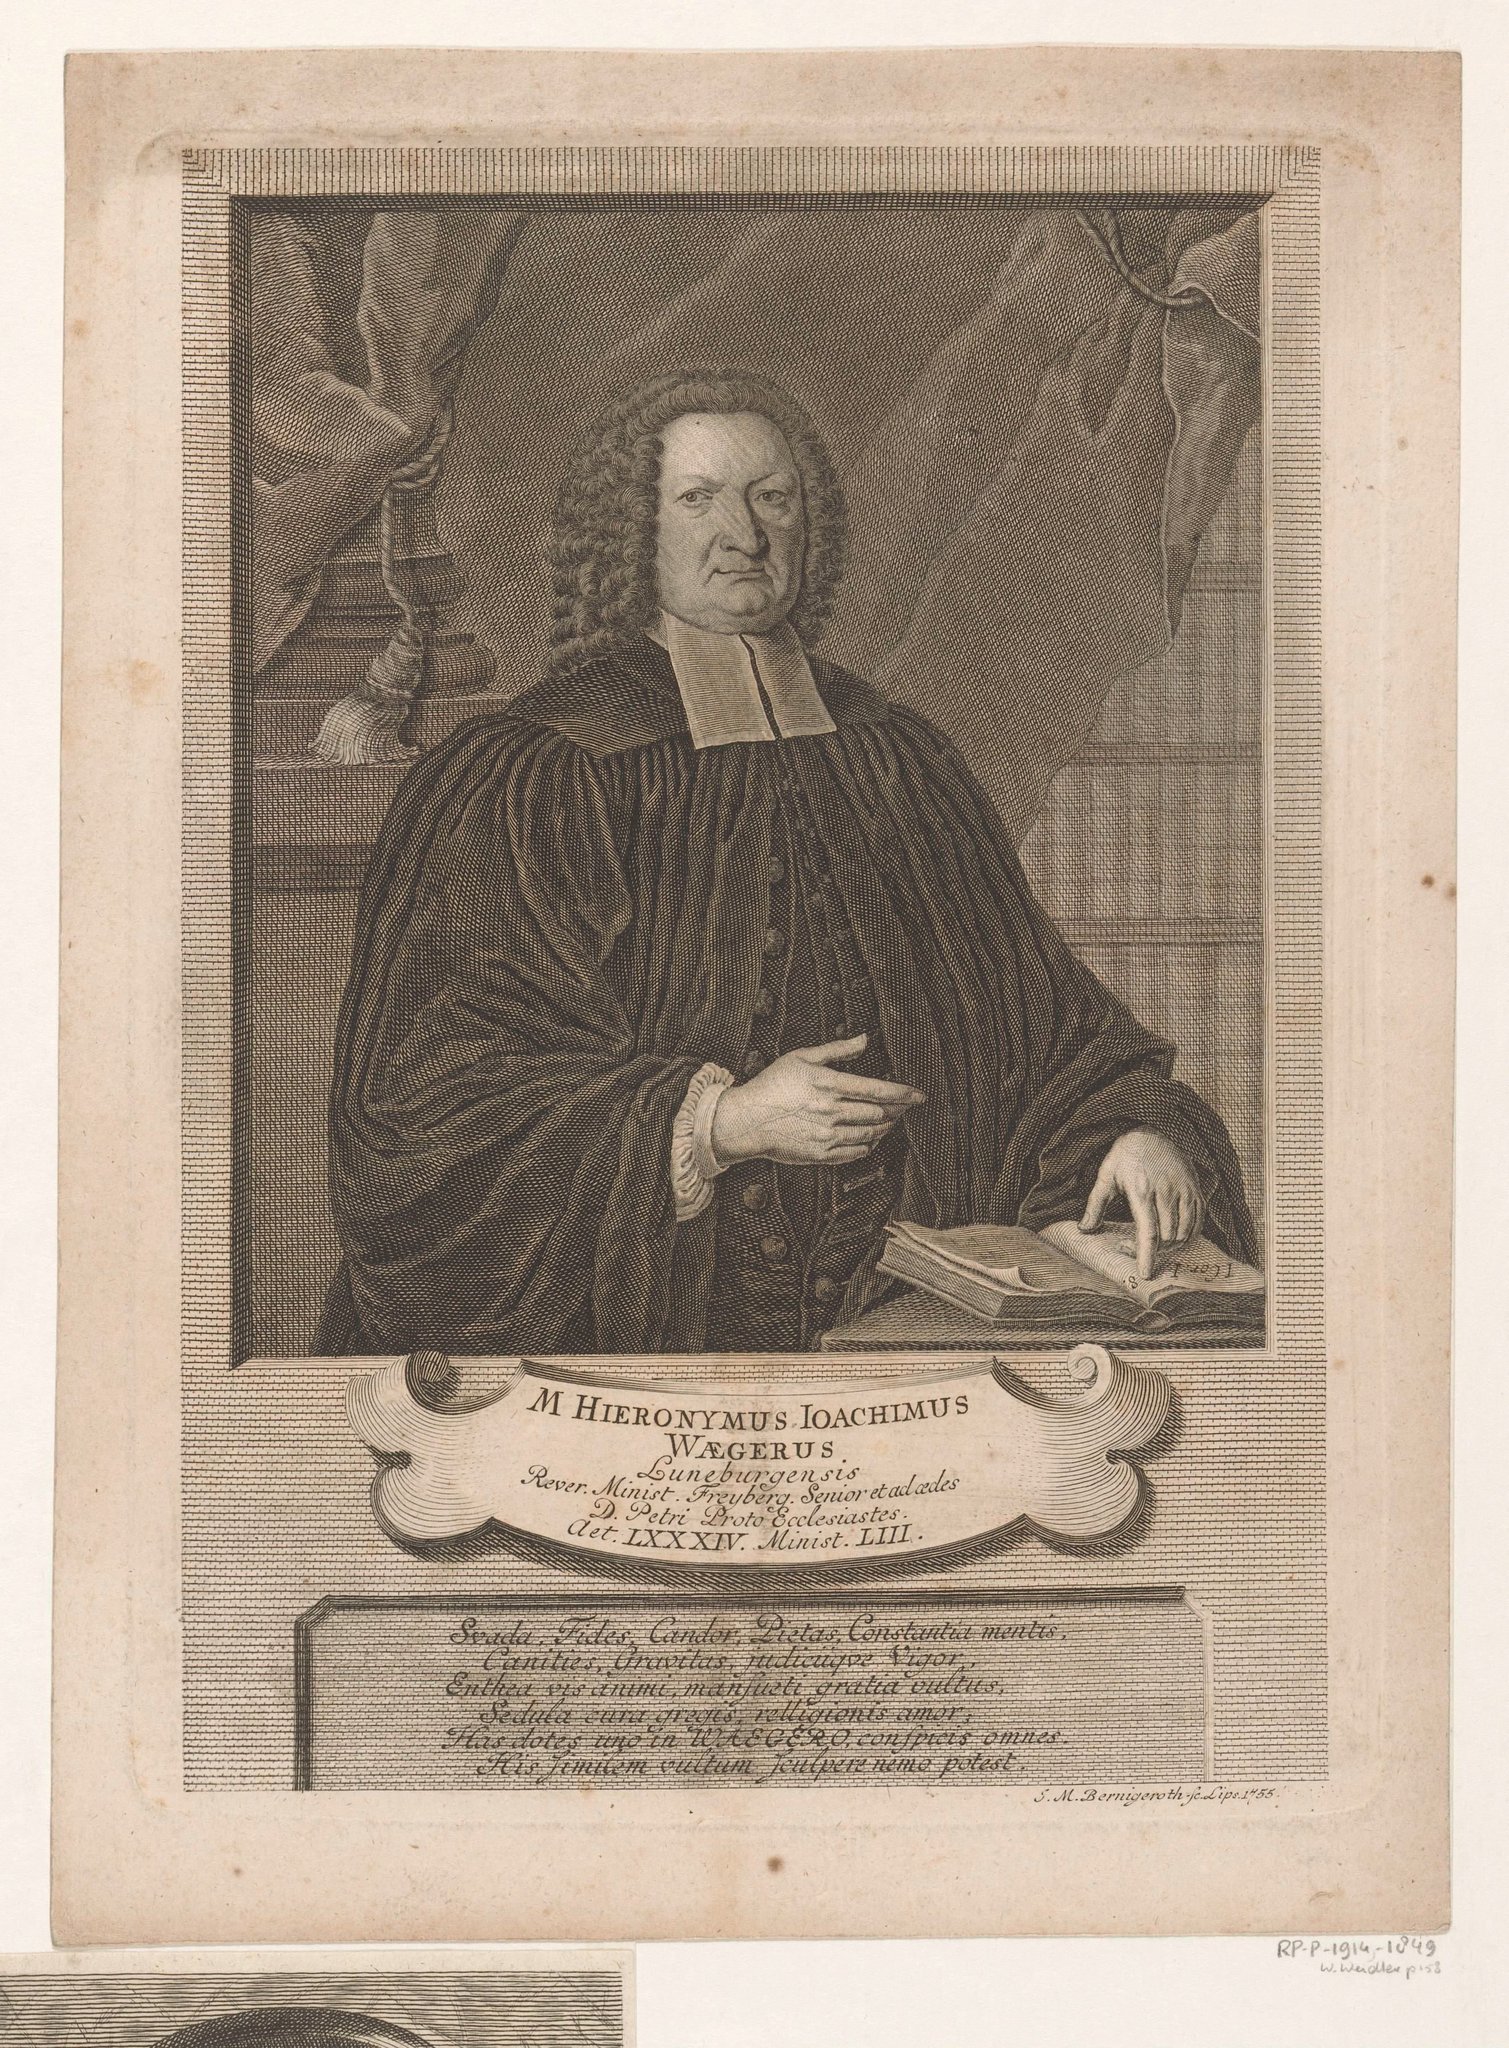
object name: print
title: Portret van Hieronymus Joachim Waeger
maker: johann martin bernigeroth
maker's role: print maker, publisher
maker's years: 1713-1767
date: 1755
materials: paper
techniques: engraving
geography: leipzig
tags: bookshelves, historical persons, book - mm - book open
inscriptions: collector's mark: Lugt 2228, check stamp: ‘[...] in Berlin’